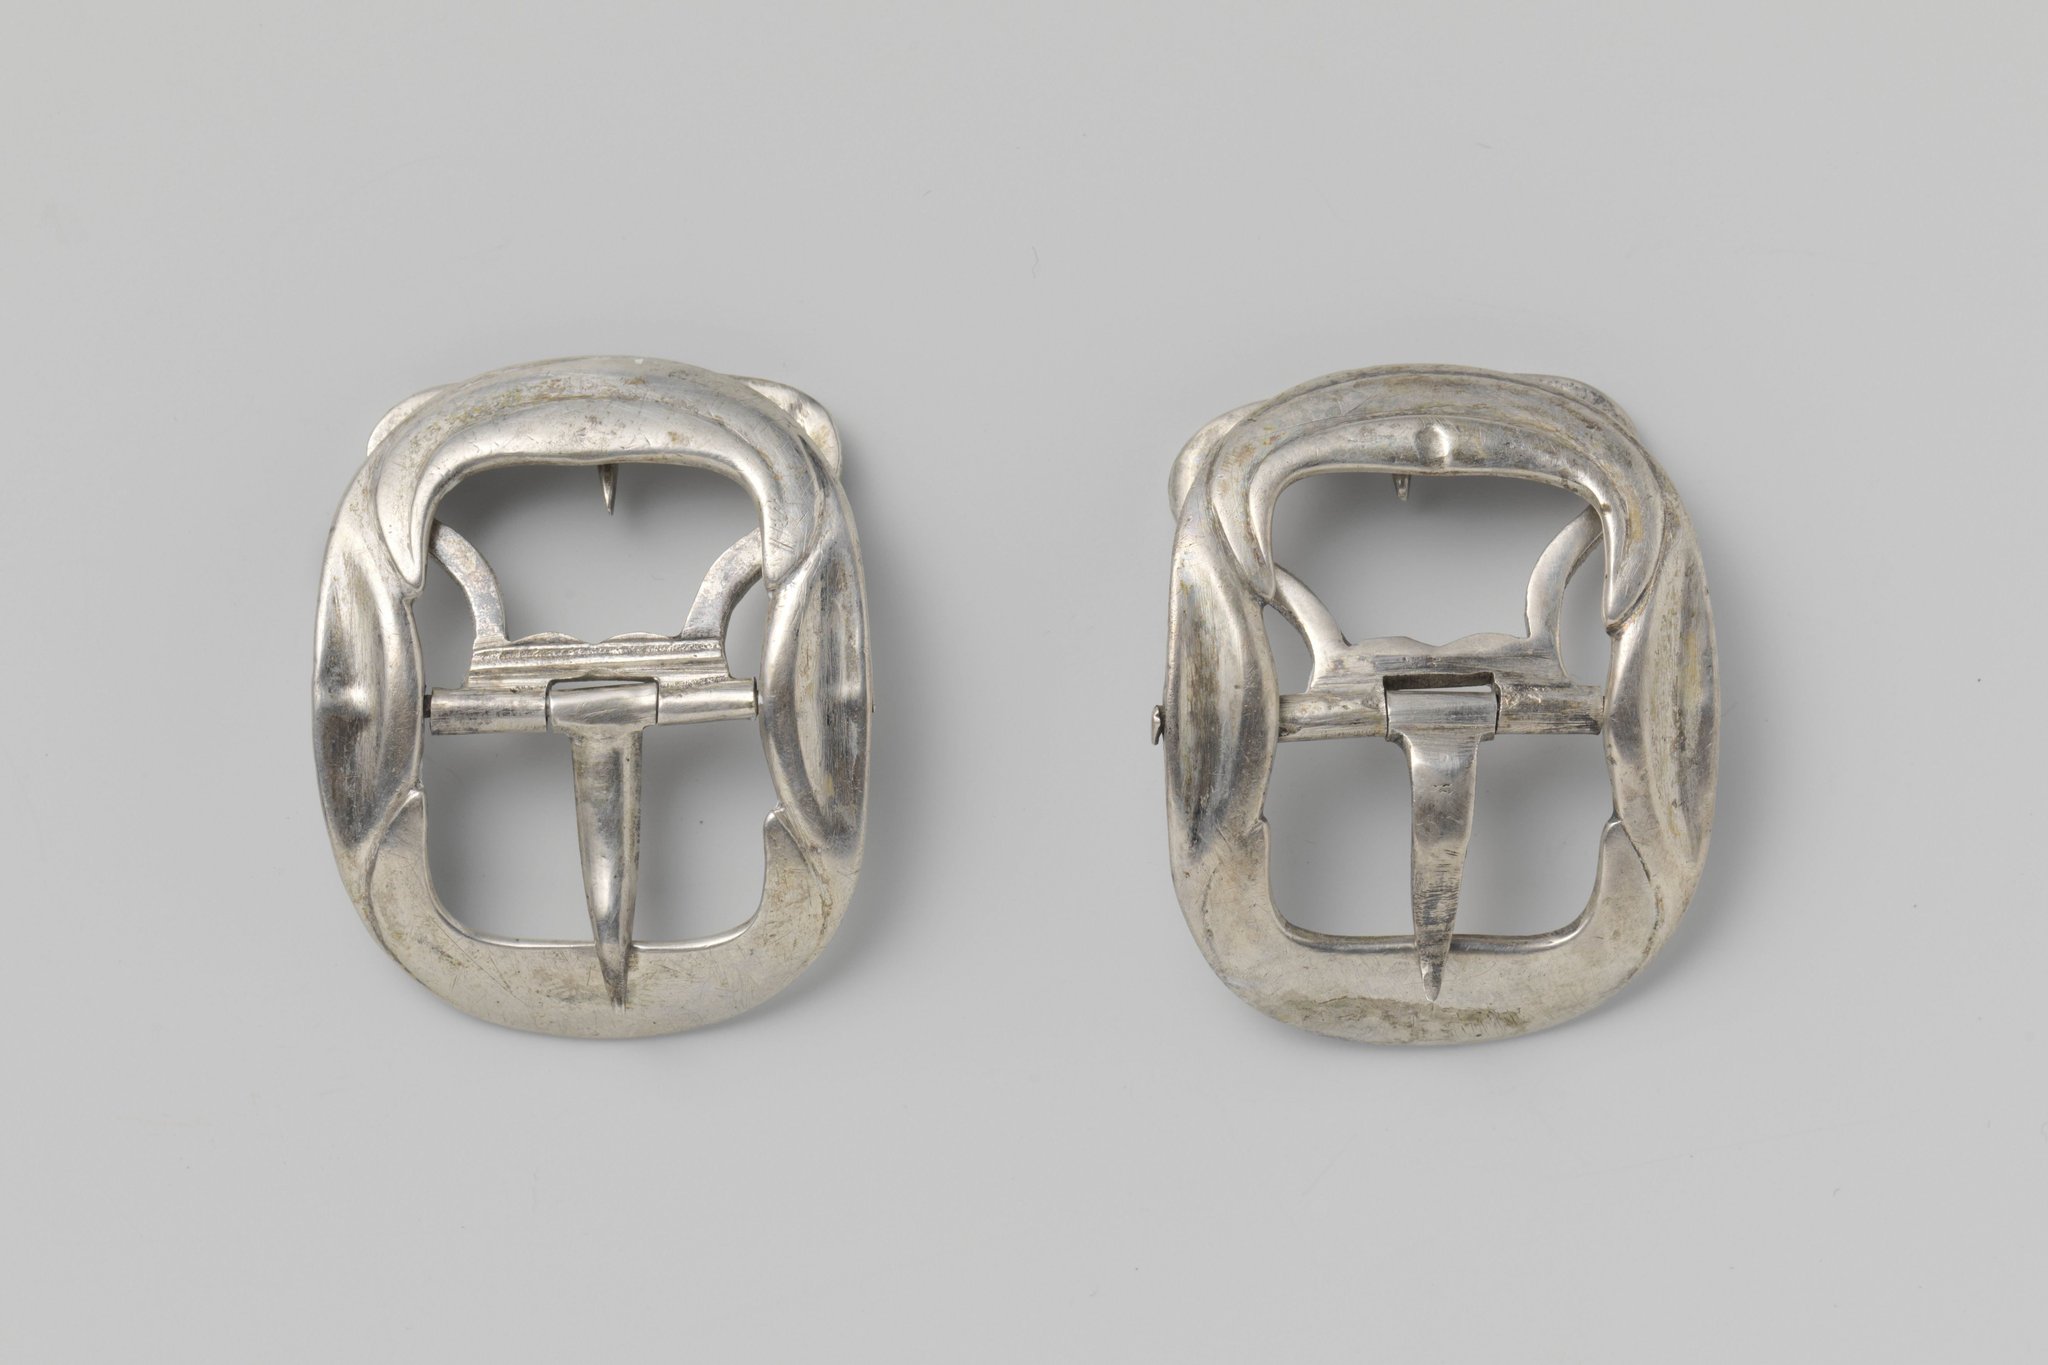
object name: clothing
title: Schoengesp van zilver, ovaalvormig met eenvoudige lijndecoratie in laagreliëf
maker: Anonymous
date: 1750-1900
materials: silver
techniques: forging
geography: western europe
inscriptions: date letter, maker's mark, town mark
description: Schoengesp van zilver, ovaalvormig met eenvoudige lijndecoratie in laagreliëf. Dubbele scharnier met een tand vanuit het midden, gemerkt.